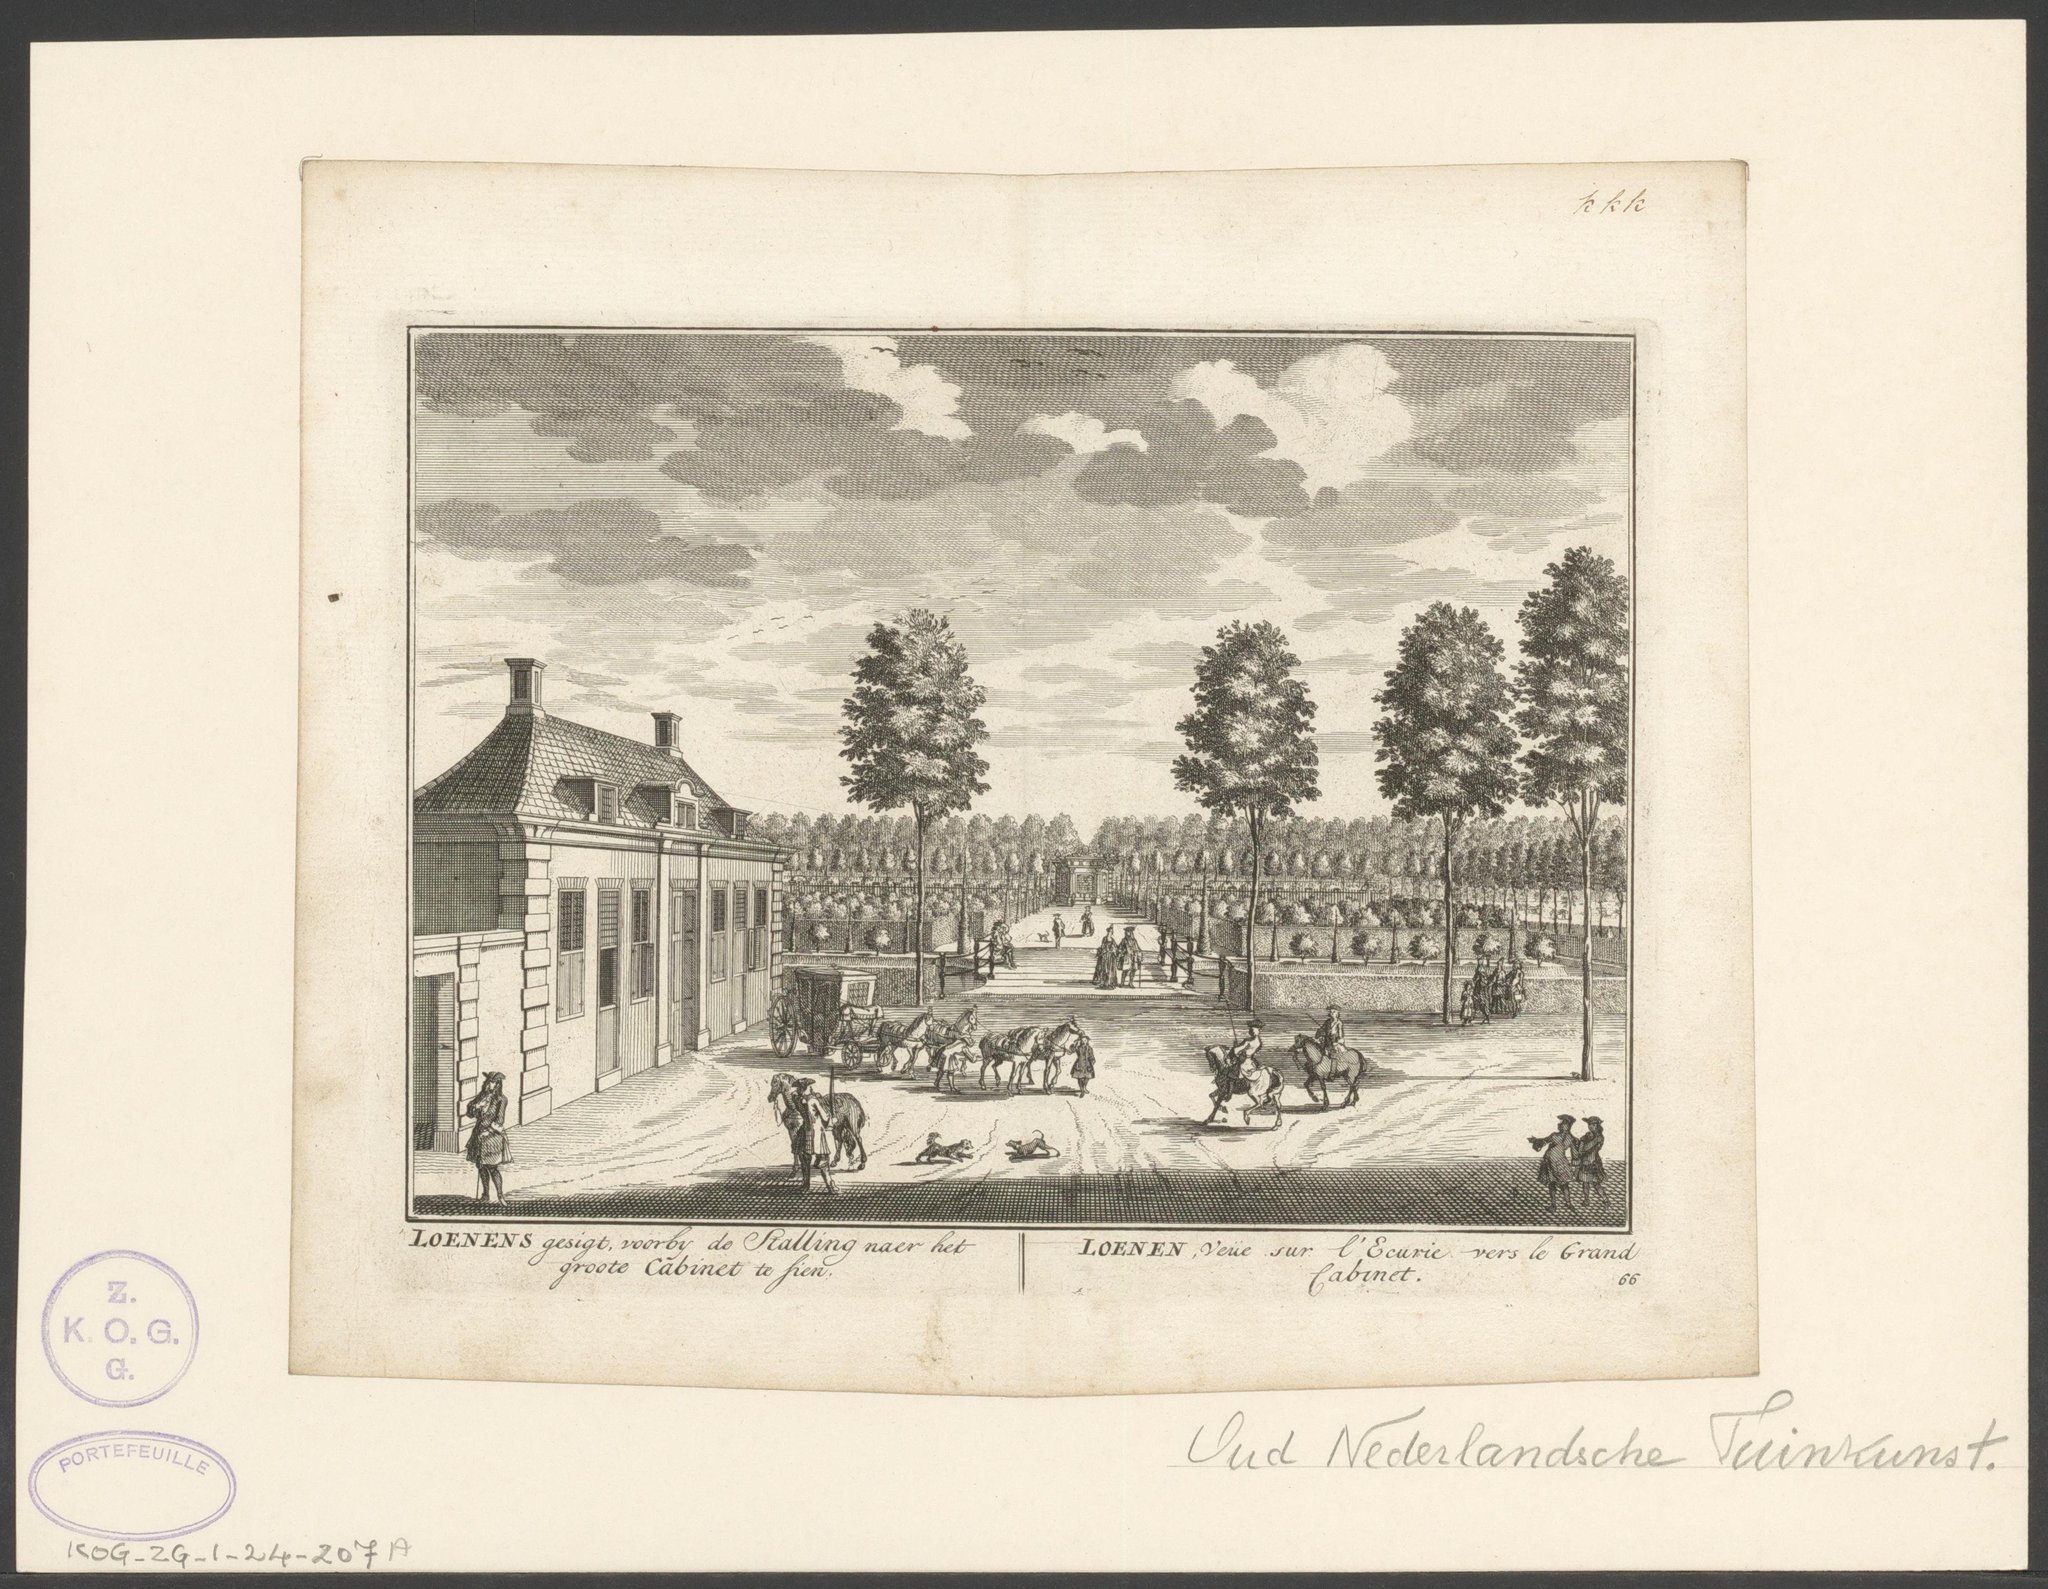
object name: print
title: Loenens gesigt, voorbij de Stalling naer het groote Cabinet te sien / Loenen, Veüe sur l'Ecurie vers le Grand Cabinet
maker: daniël stopendaal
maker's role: print maker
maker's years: 1672-1726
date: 1719-1790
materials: paper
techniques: engraving, etching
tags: country-house, vecht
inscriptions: collector's mark: Lugt 1641, stamp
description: Prent voor het eerst gebruikt in: Leth, Andries de. De zegepraalende Vecht, vertoonende verscheidene gesichten van lustplaatsen, heeren huysen en dorpen, beginnende van Uitrecht en met Muyden besluytende (...). Amsterdam: Weduwe Nicolaus Visscher, 1719. Prent mogelijk uit: Brouërius van Nidek, Matthaeus. De Vechtstroom, van Utrecht tot Muiden (...). Amsterdam: H. Gartman, W. Vermandel en J.W. Smit, 1790.